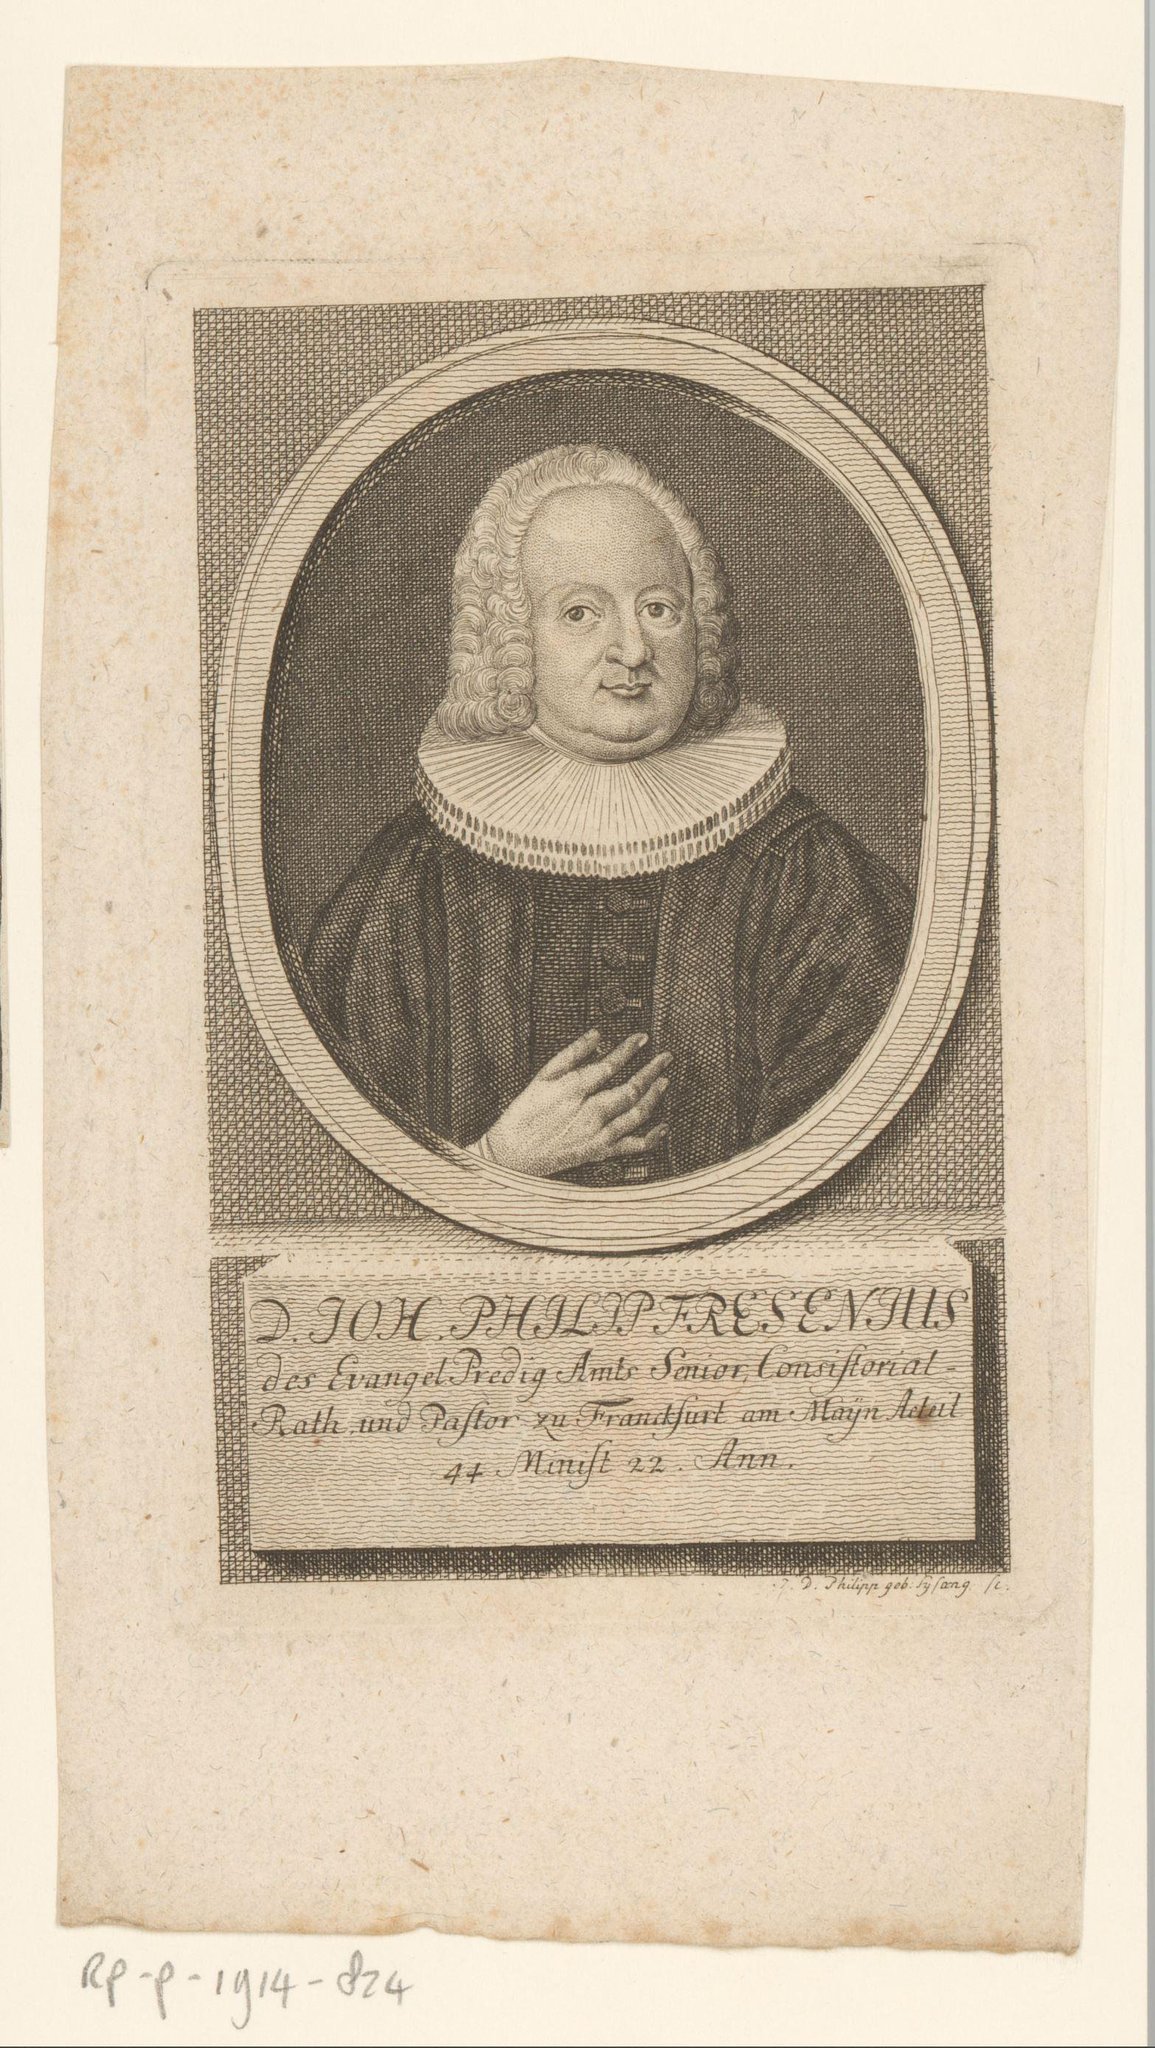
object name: print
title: Portret van Johann Philipp Fresenius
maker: johanna dorothea sysang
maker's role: print maker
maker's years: 1729-1791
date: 1739-1791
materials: paper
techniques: engraving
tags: historical persons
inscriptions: collector's mark: Lugt 2228